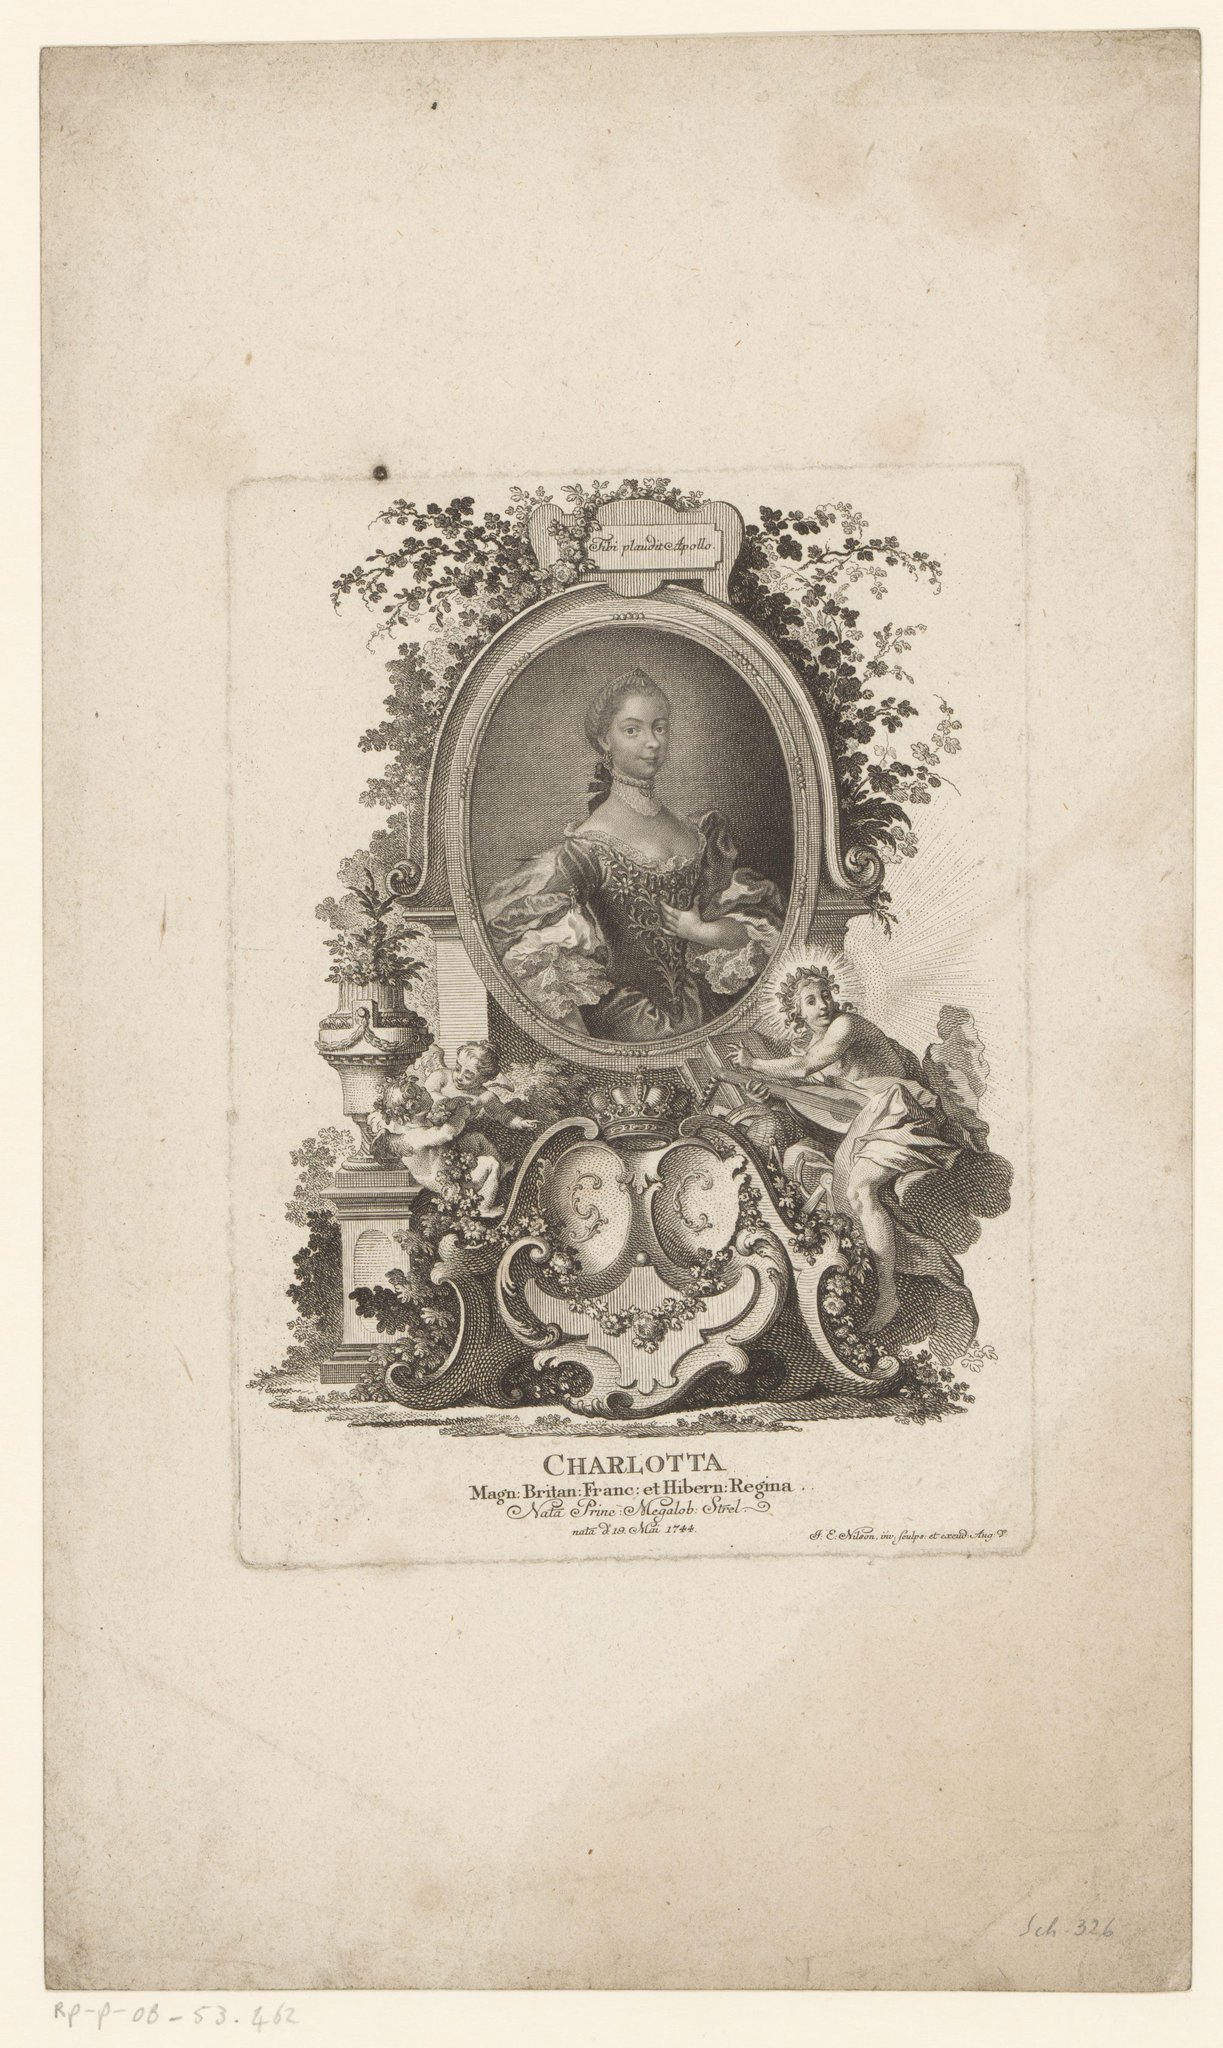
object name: print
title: Portret van Charlotte van Mecklenburg, koningin van Groot-Brittannië en Ierland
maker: johann esaias nilson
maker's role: draughtsman, print maker, publisher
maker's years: 1721-1788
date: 1731-1788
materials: paper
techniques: engraving, etching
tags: london, charlotte van mecklenburg (koningin van groot-brittannië en ierland), the liberal arts, 'artes liberales', historical persons - bb - woman, insignia and symbols of sovereignty (crown, diadem, sceptre, orb, seal, standard, cloak, pectoral)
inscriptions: collector's mark: Lugt 2228